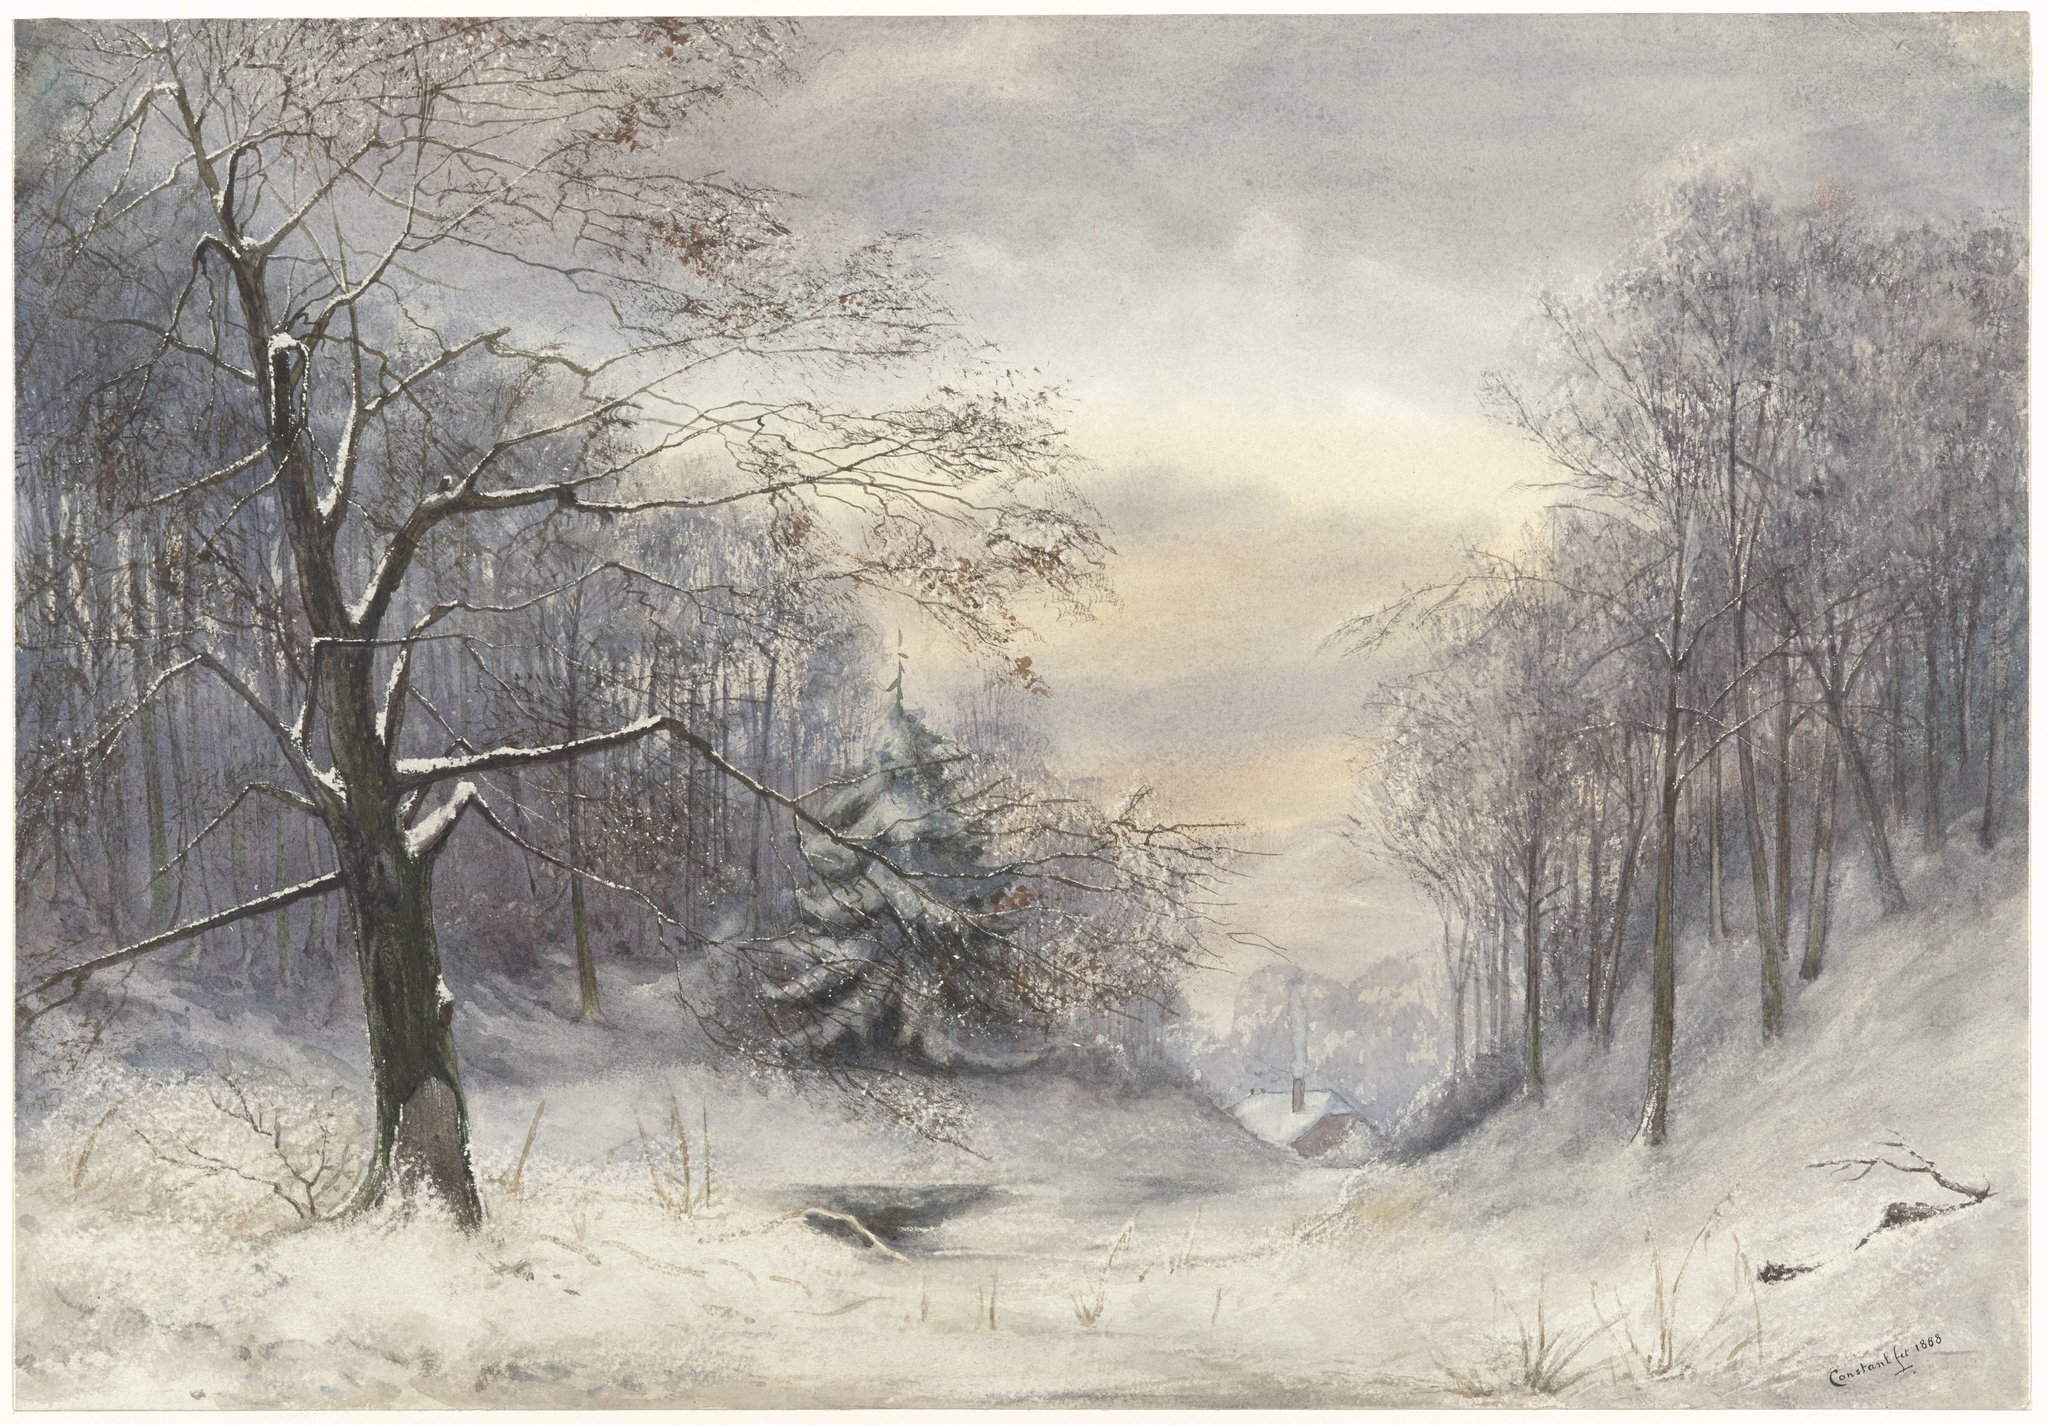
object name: drawing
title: Winterlandschap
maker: jan daniël cornelis carel willem baron de constant rebecque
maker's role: draughtsman, print maker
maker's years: 1841-1893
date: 1888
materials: chalk, paper, watercolor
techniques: brush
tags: forest, wood, snow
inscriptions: date: ‘1888’